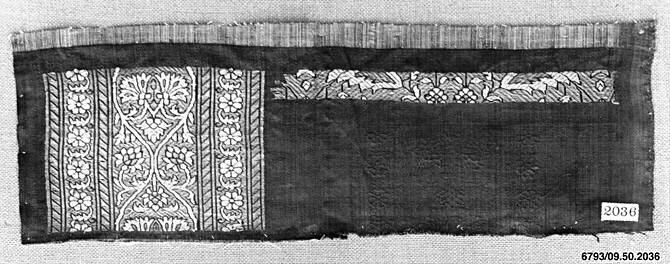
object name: textile fragment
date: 1801-1900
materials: metal thread, silk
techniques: brocade, satin weave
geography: india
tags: flowers